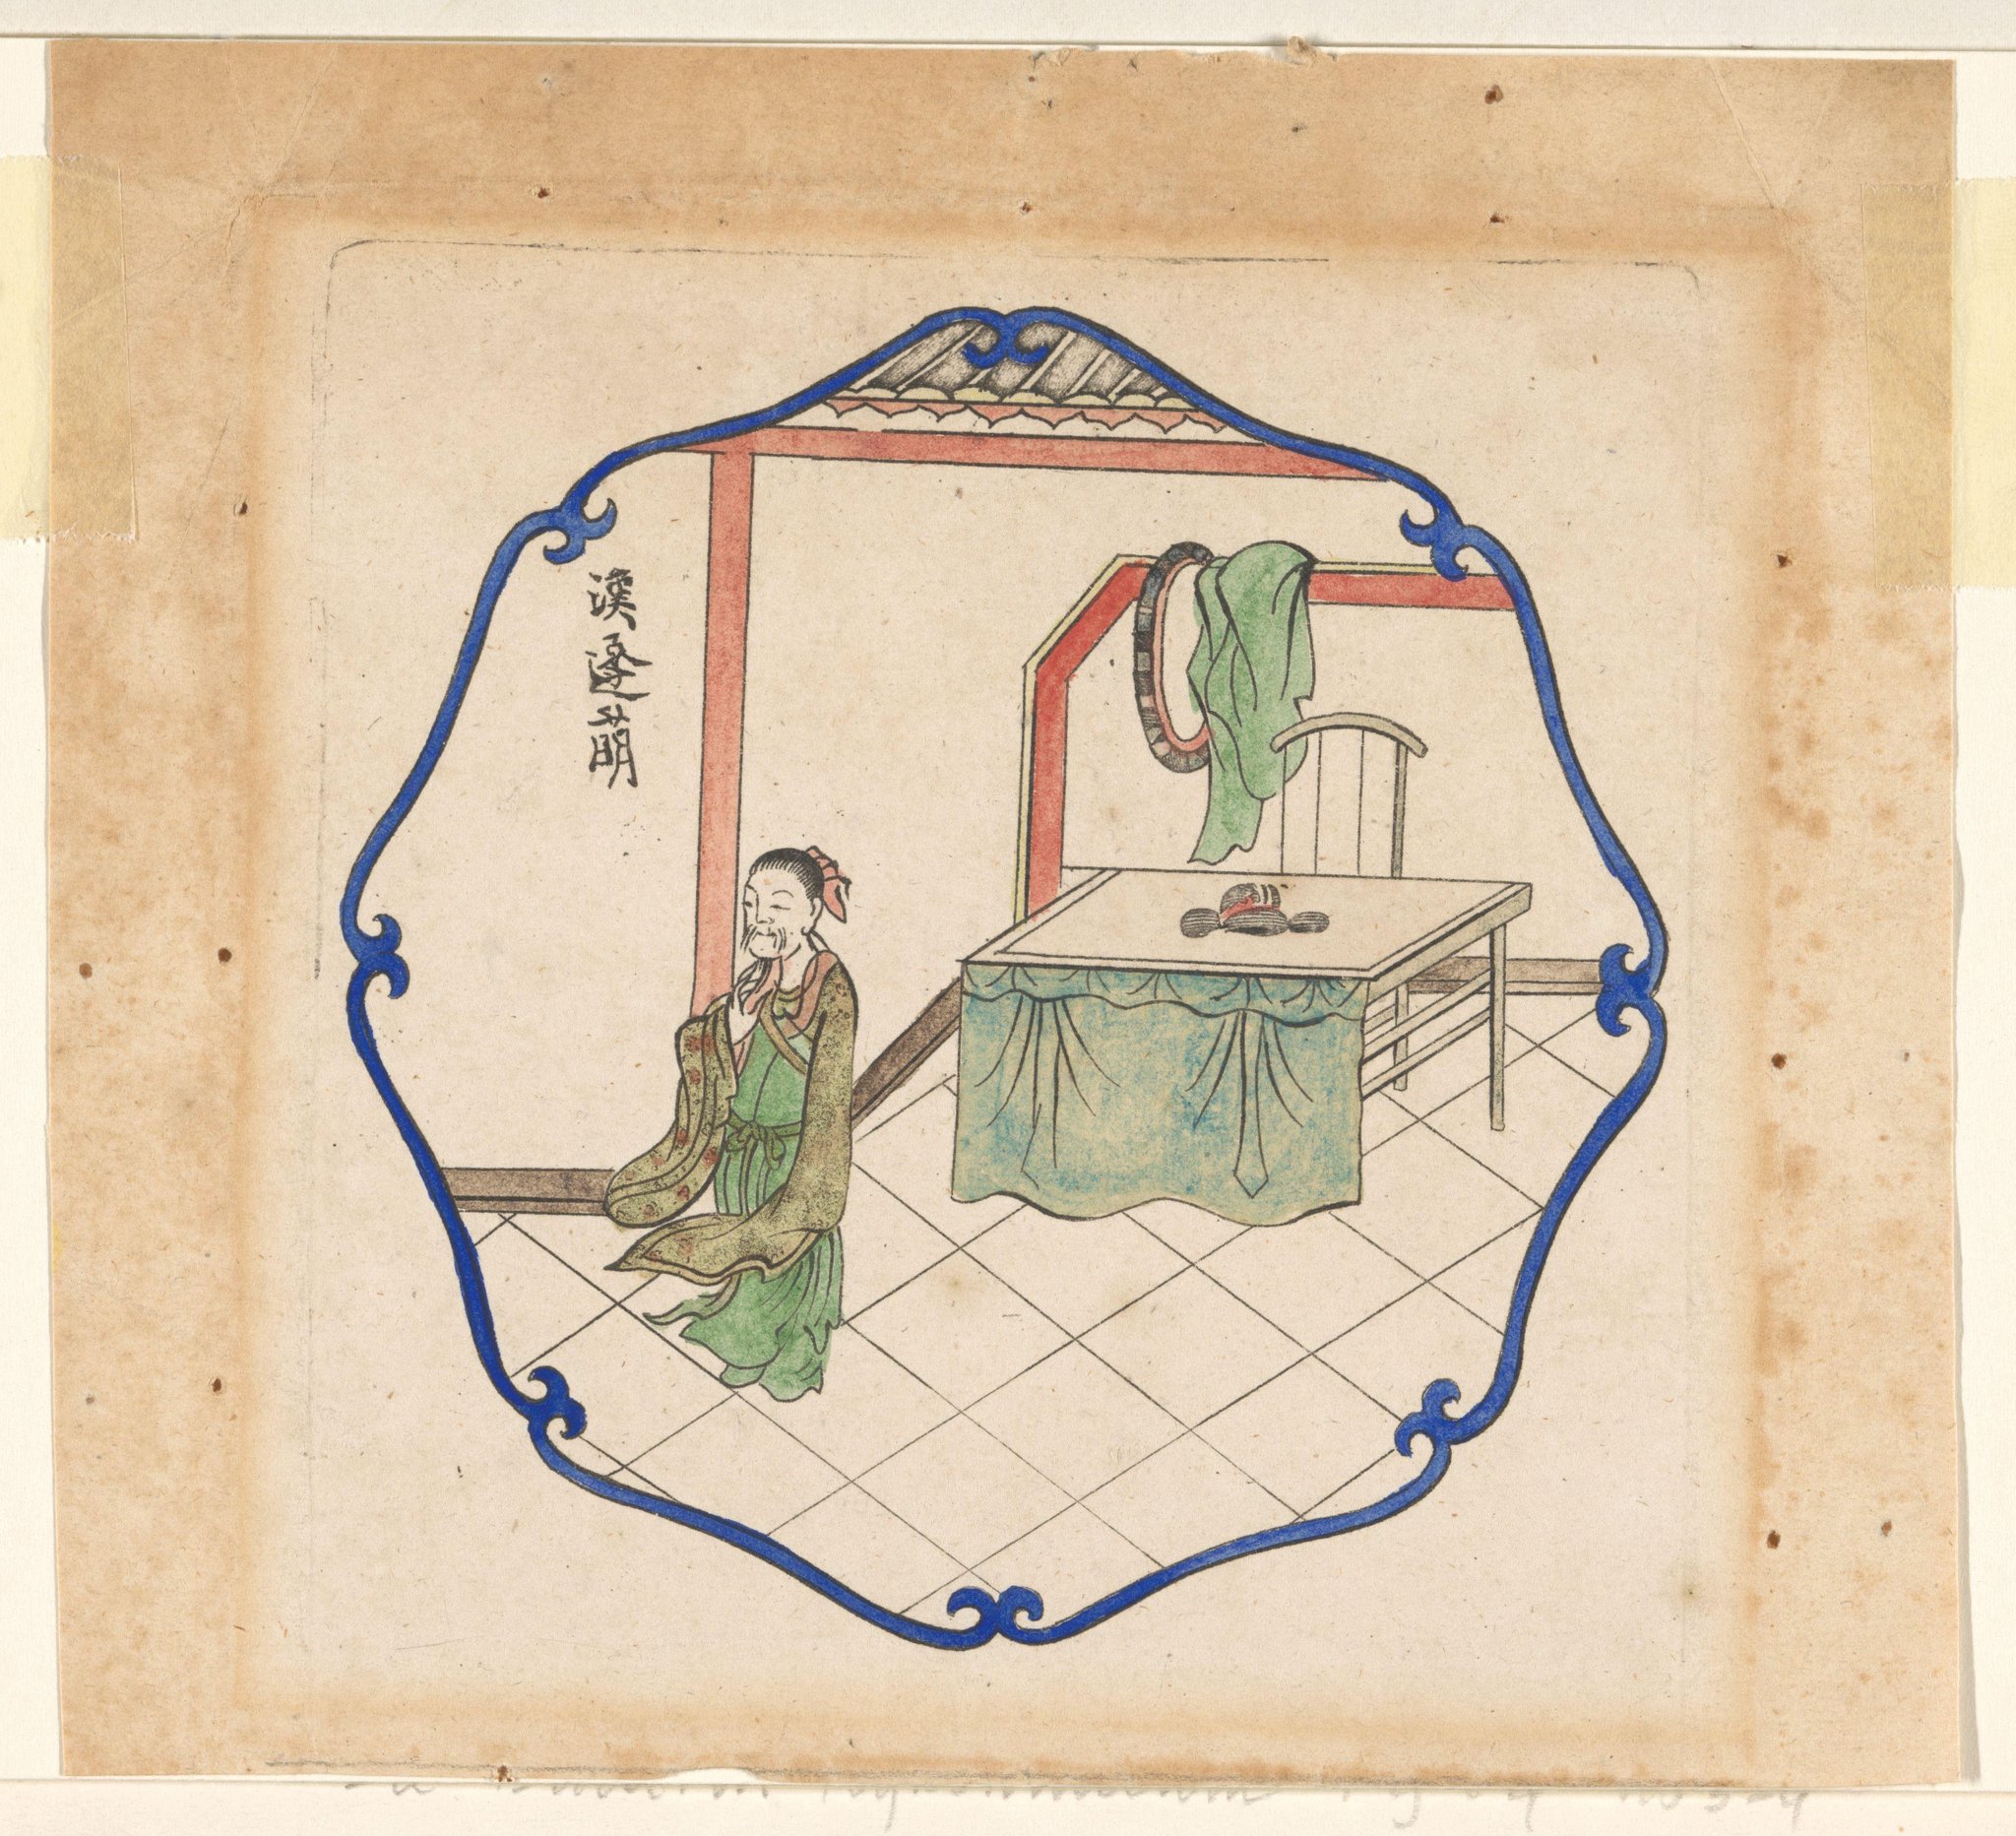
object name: print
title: Feng Meng of the Han Dynasty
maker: pieter schenk (i)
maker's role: print maker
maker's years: 1660-1711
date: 1702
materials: paper, watercolor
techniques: etching, hand coloring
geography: amsterdam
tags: chinese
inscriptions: collector's mark: Lugt 2760, collector's mark: Lugt 2228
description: Schenk the elder depicted T’ao Ch’ien looking over his flower garden, enjoying his retirement from civic service. These etchings are two of eight roundels illustrating Chinese history, which Schenk copied from Chinese woodcuts. Using watercolour, these handcoloured prints mimick the chinoiserie designs on Meissen and Delftware, such as the vase and beer tankard also on display.